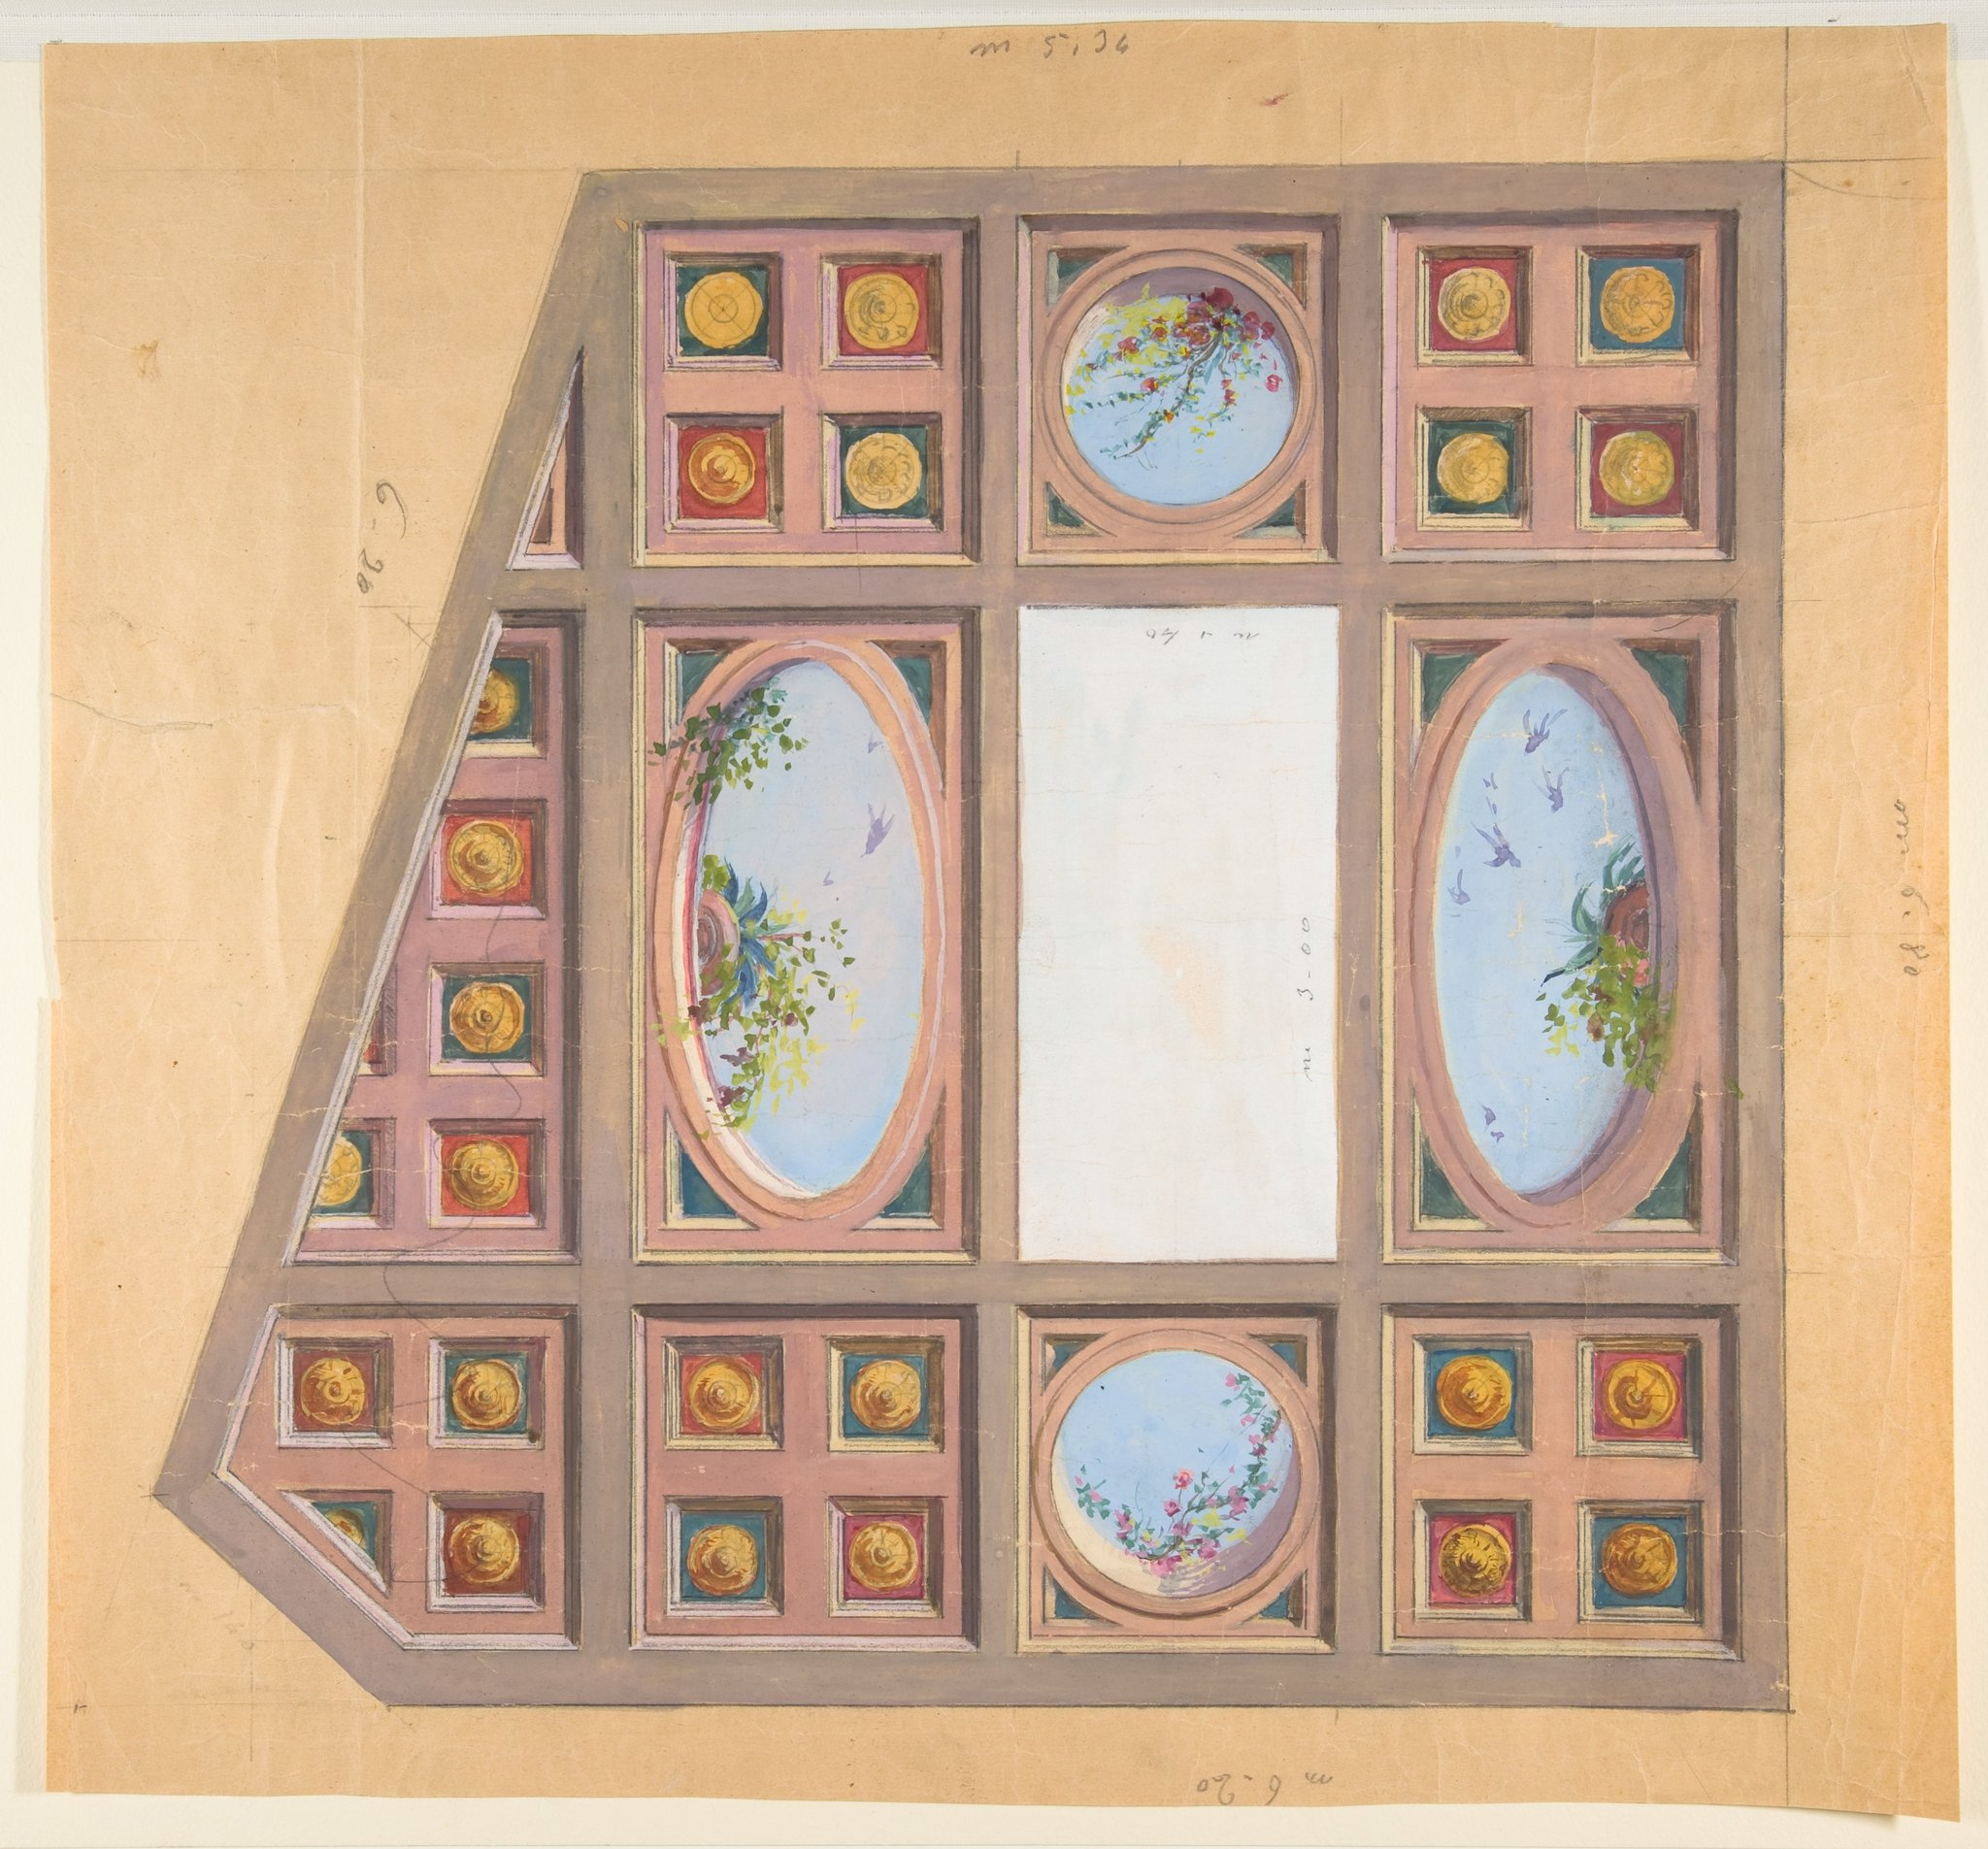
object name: drawing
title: Design for a ceiling decoration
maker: anonymous, french, 19th century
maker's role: artist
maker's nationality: french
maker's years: 1800-1900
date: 1801-1900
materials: graphite, watercolor